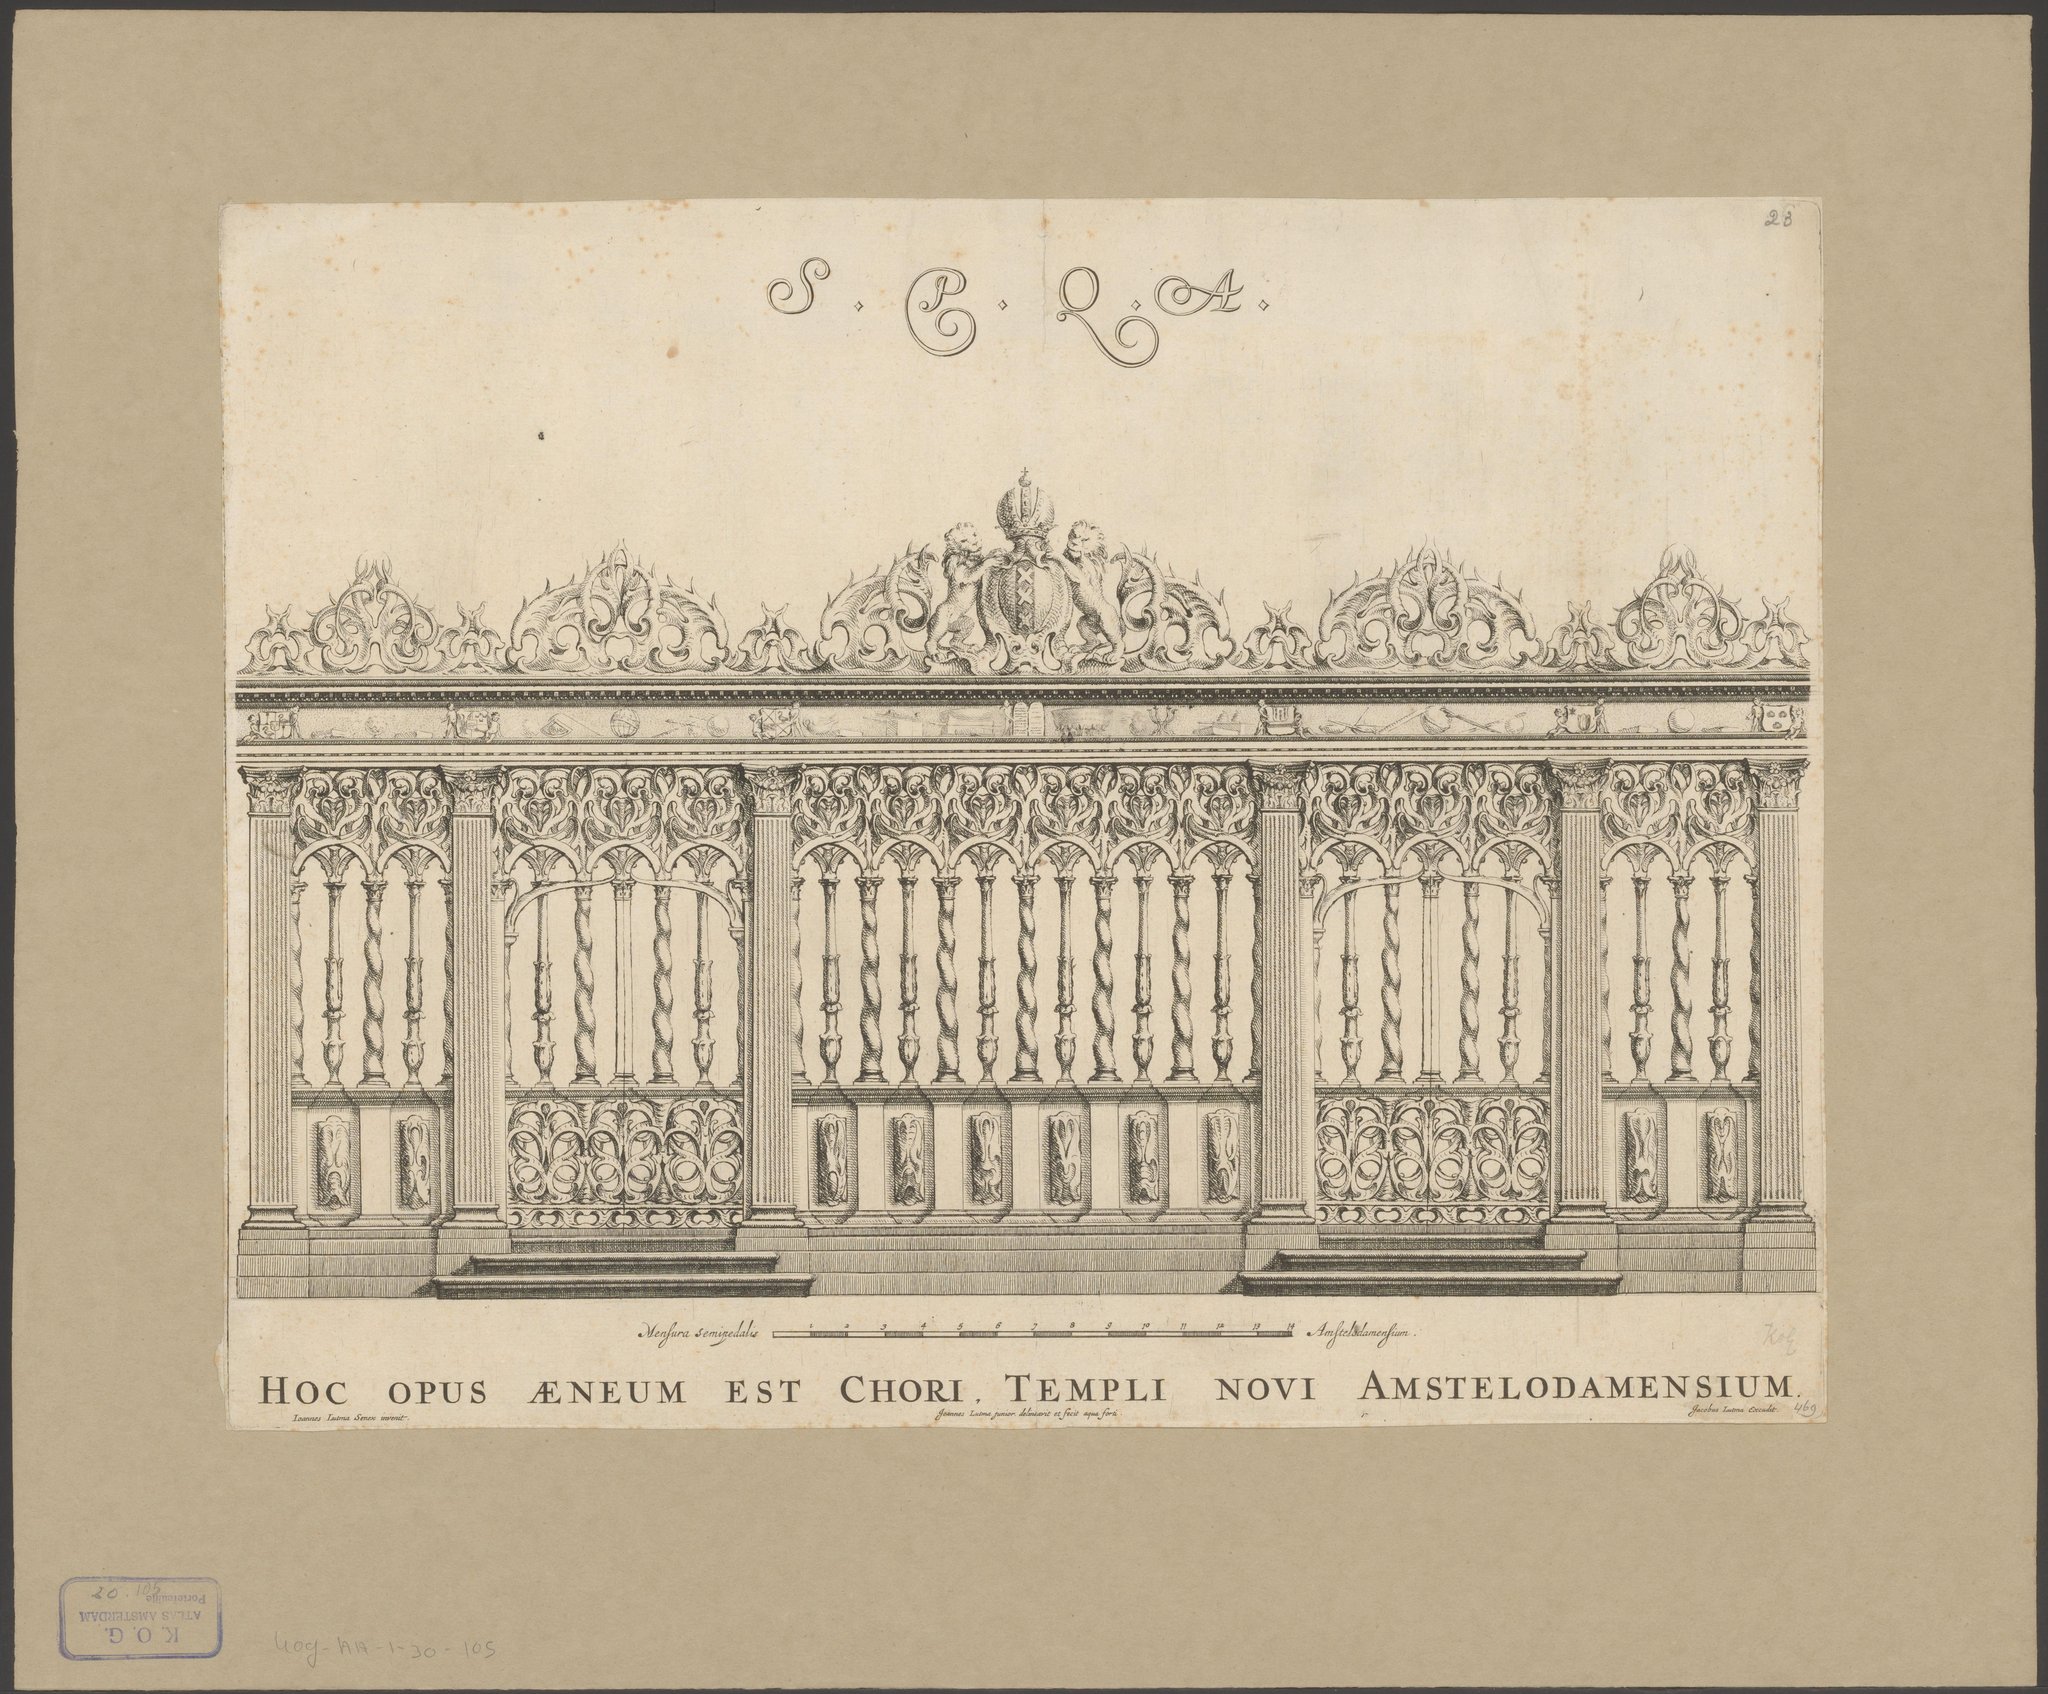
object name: print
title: Hoc opus aeneum est chori, Templi Novi Amstelodamensium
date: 1645-1654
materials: paper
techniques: engraving, etching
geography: amsterdam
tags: coat of arms (as symbol of the state, etc.) (+ city; municipal), rood-screen, choir-screen; iconostasis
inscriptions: collector's mark: Lugt 1641b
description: Koorhek met pilasters, getorste zuilen en kwabornamenten, bekroond door twee leeuwen met het wapen van Amsterdam. Boven het hek de tekst S.P.Q.A. Onder het hek de titel en een schaalstok: Mensura Semipedalis Amstelodamensium. Onderwerpsrubriek binnen de Atlas Amsterdam: Kerkwezen: Hervormde Gemeente: Nieuwe Kerk van binnen.